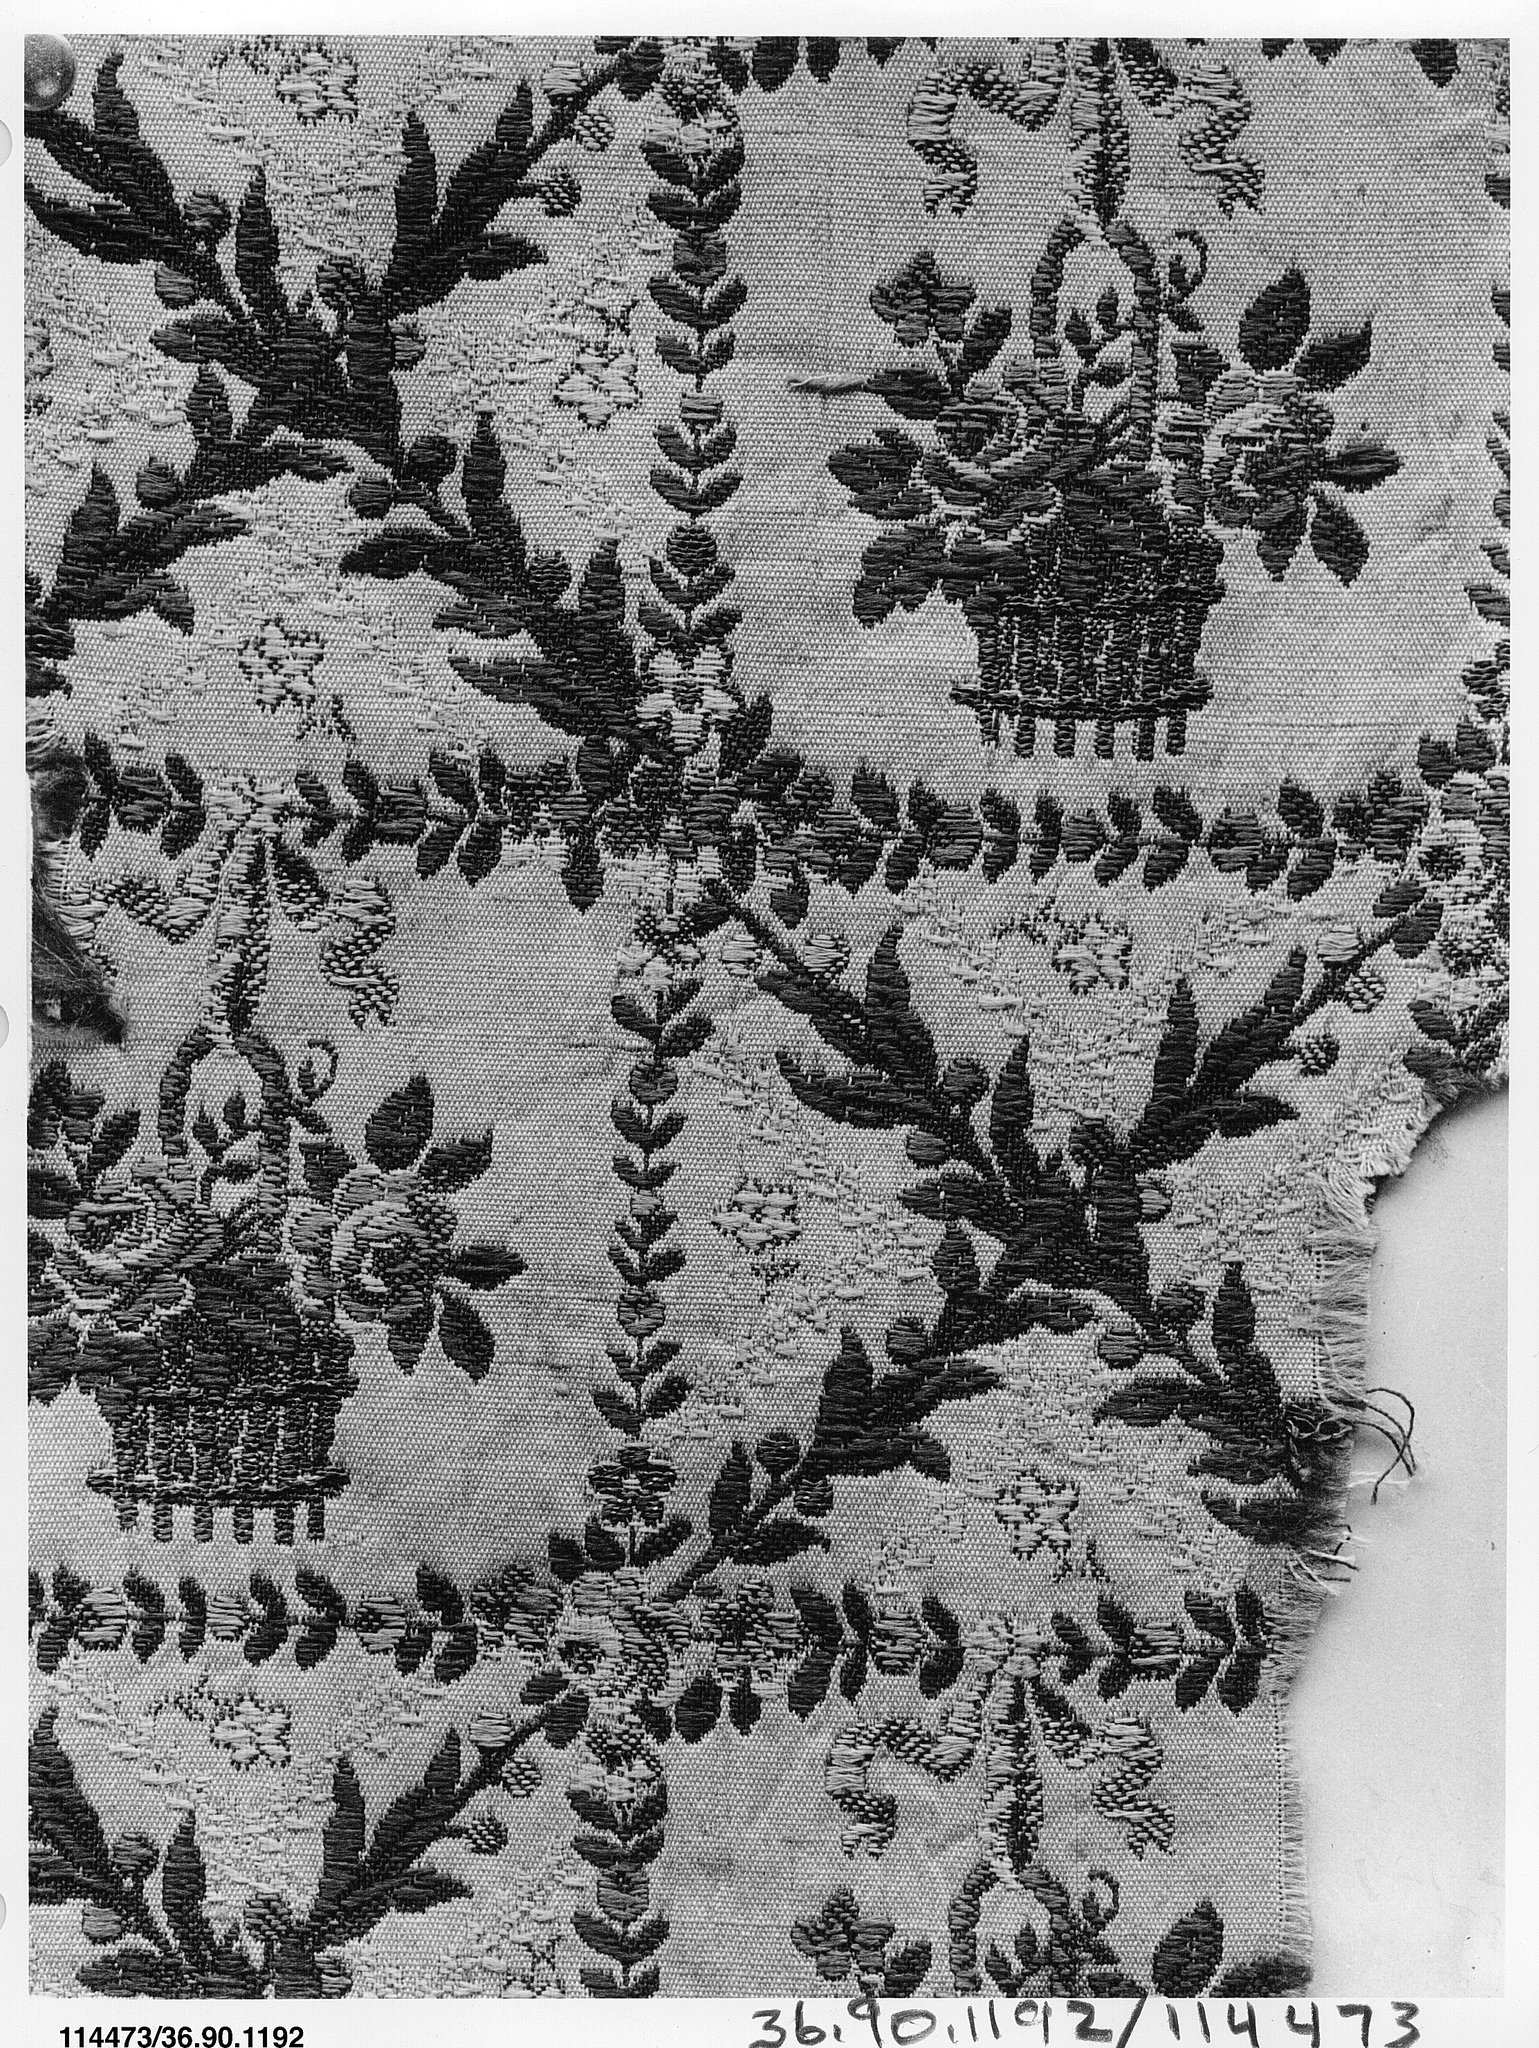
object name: piece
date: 1801-1900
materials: metal thread, silk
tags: flowers,leaves